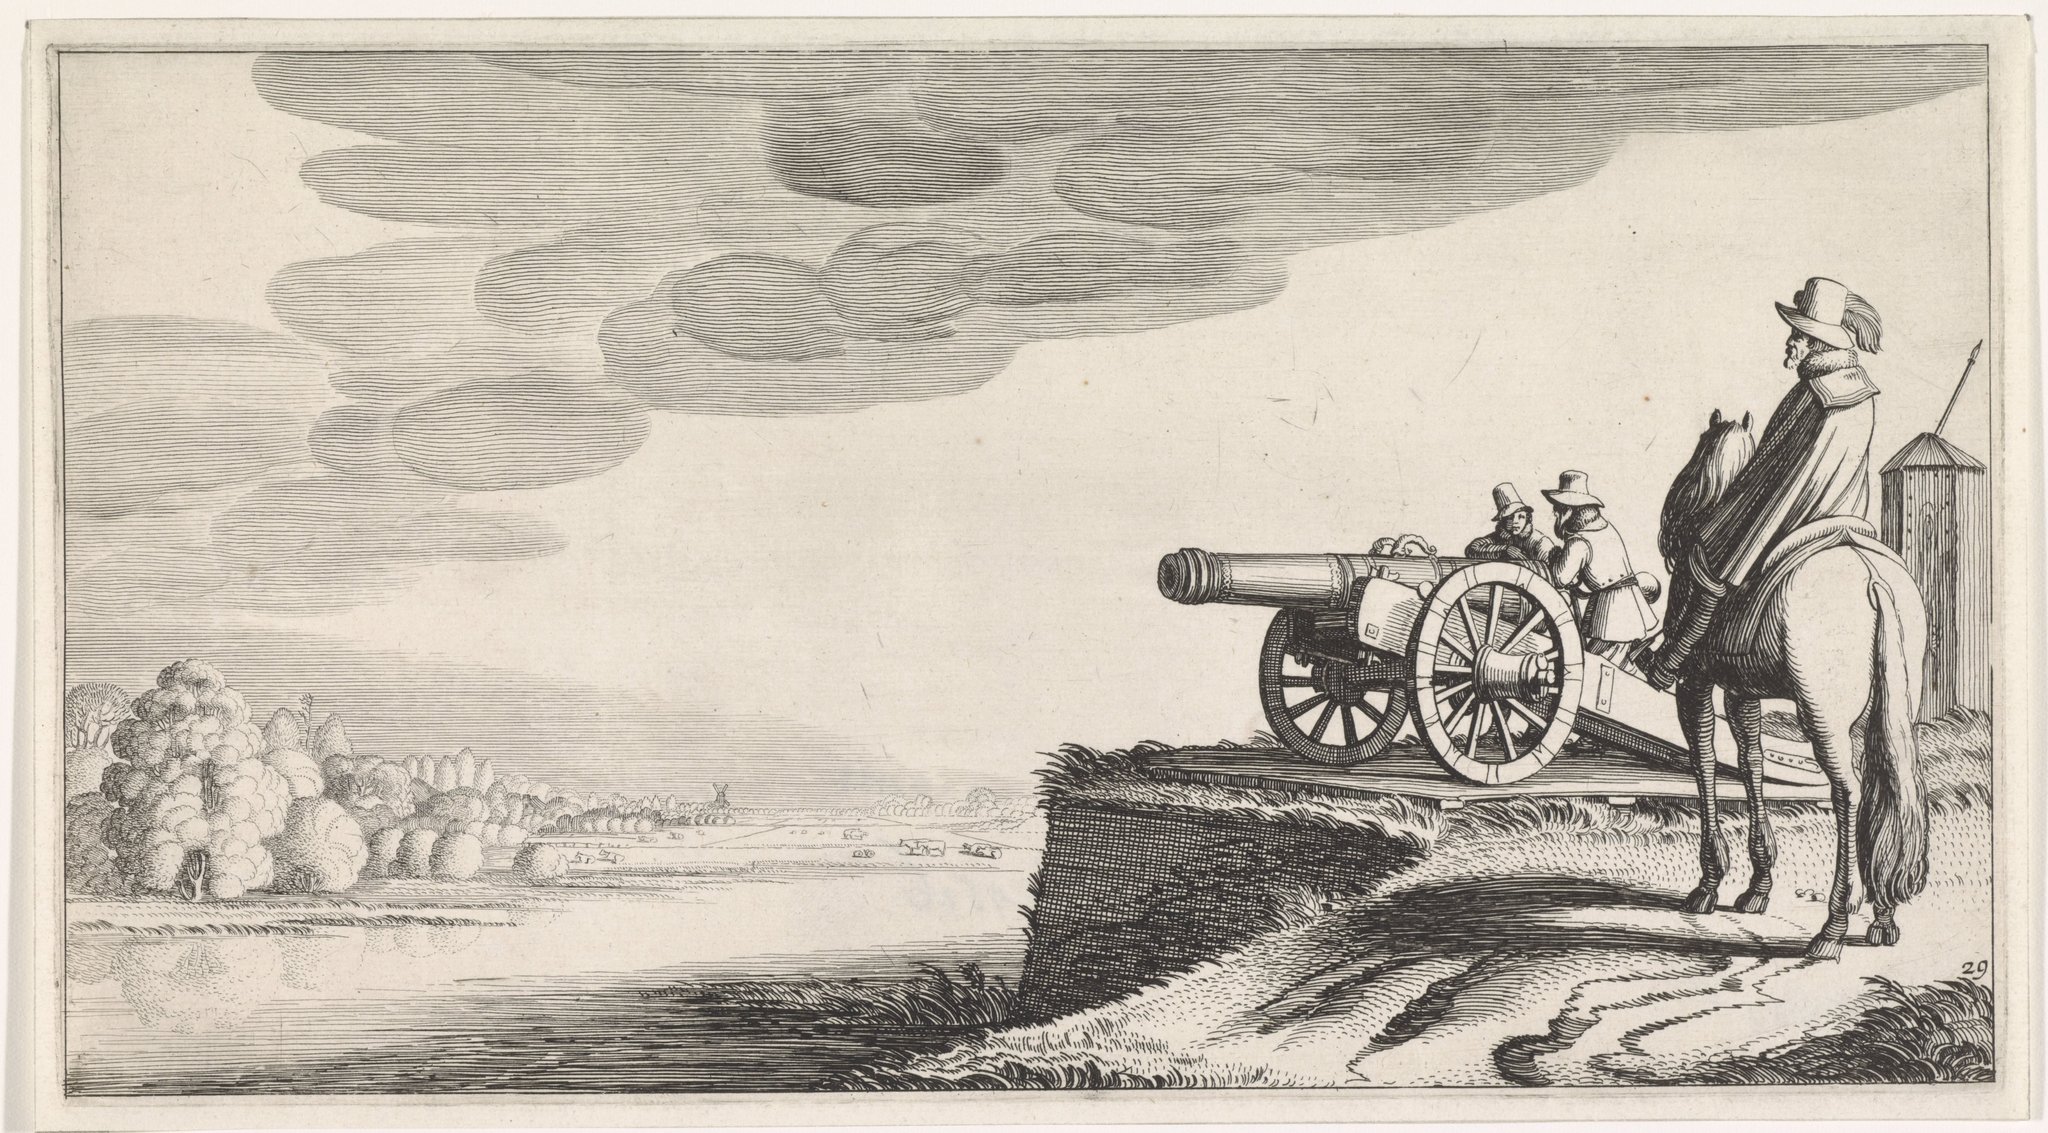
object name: print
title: Playsante lantschappen ende vermakelycke gesichten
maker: jan van de velde (ii)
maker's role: draughtsman, painter, print maker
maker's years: 1593-1641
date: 1639-1641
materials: paper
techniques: etching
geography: northern netherlands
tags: riding a horse, ass, or mule; rider, horseman, river, firearms: cannon, the soldier; the soldier's life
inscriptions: collector's mark: Lugt 964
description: Een ruiter en twee soldaten bij een kanon op een rivieroever. 29ste prent van een serie met 36 prenten van landschappen, verdeeld over zes delen.